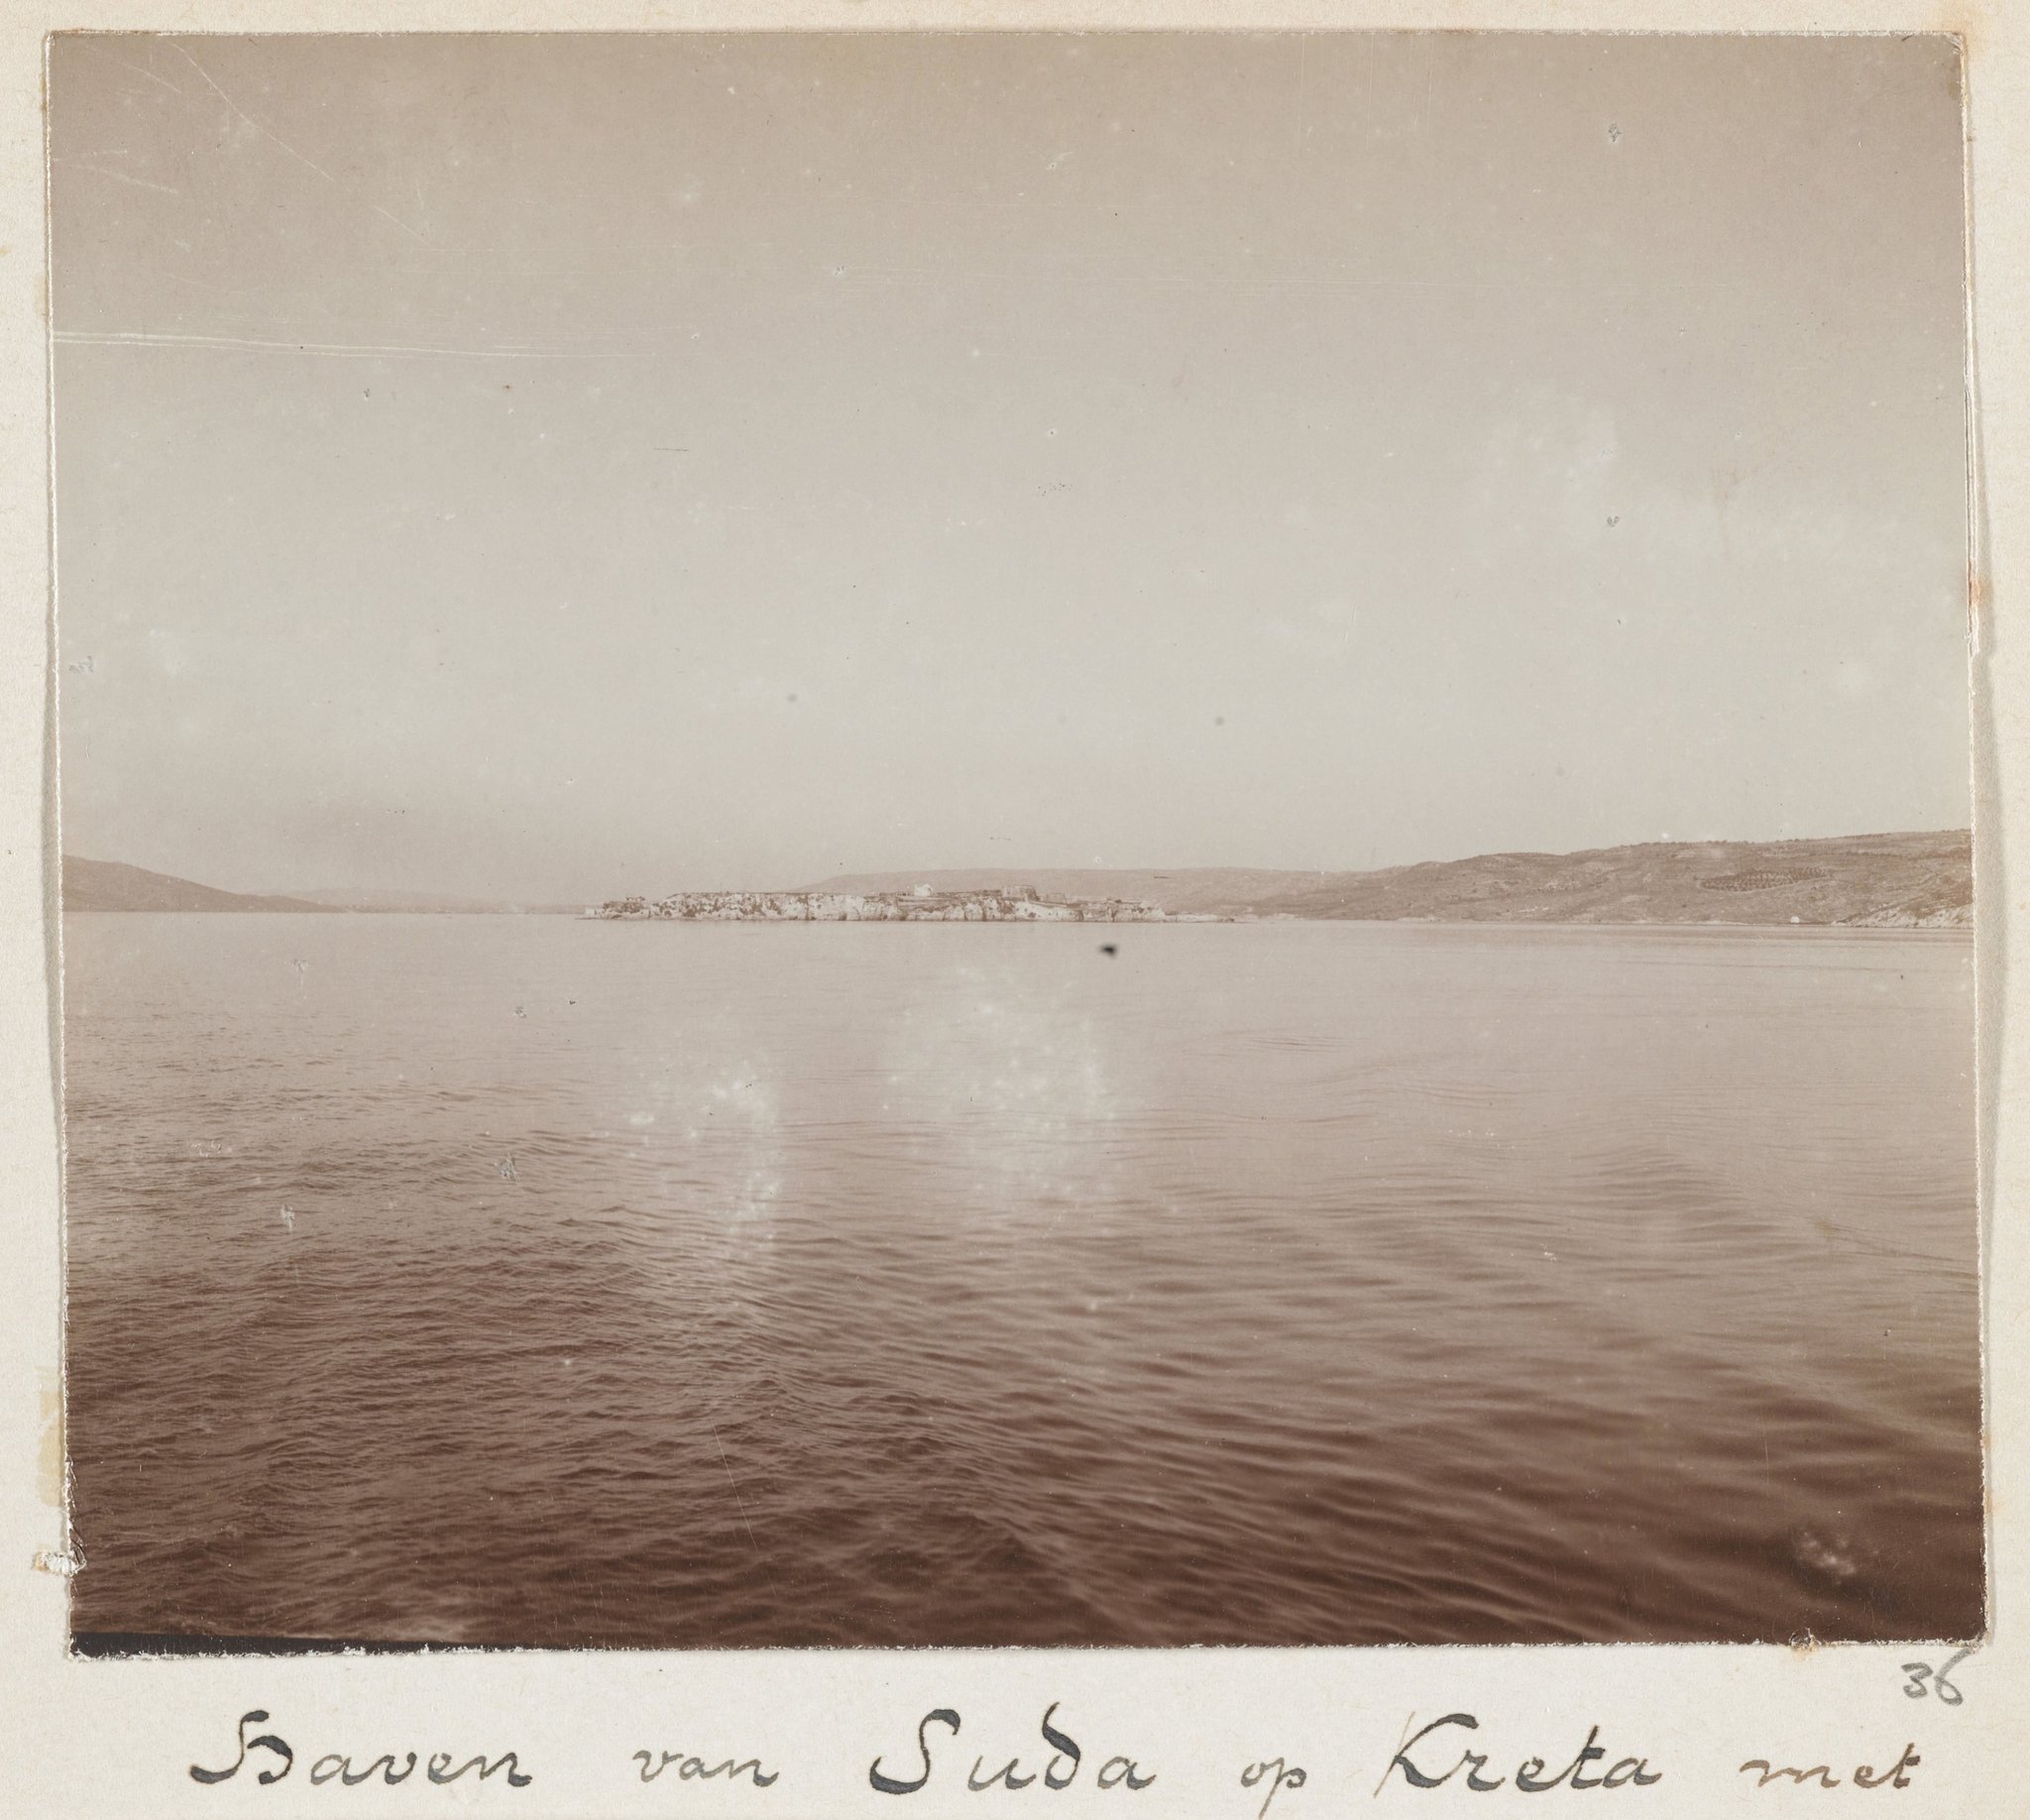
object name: photograph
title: Gezicht op Souda (nu Chania) op Kreta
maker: johannes lodewijk heldring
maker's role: fotograaf, predikant, schrijver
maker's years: 1852-1923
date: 1898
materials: paper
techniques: collodion silver print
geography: creta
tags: city-view in general; 'veduta'